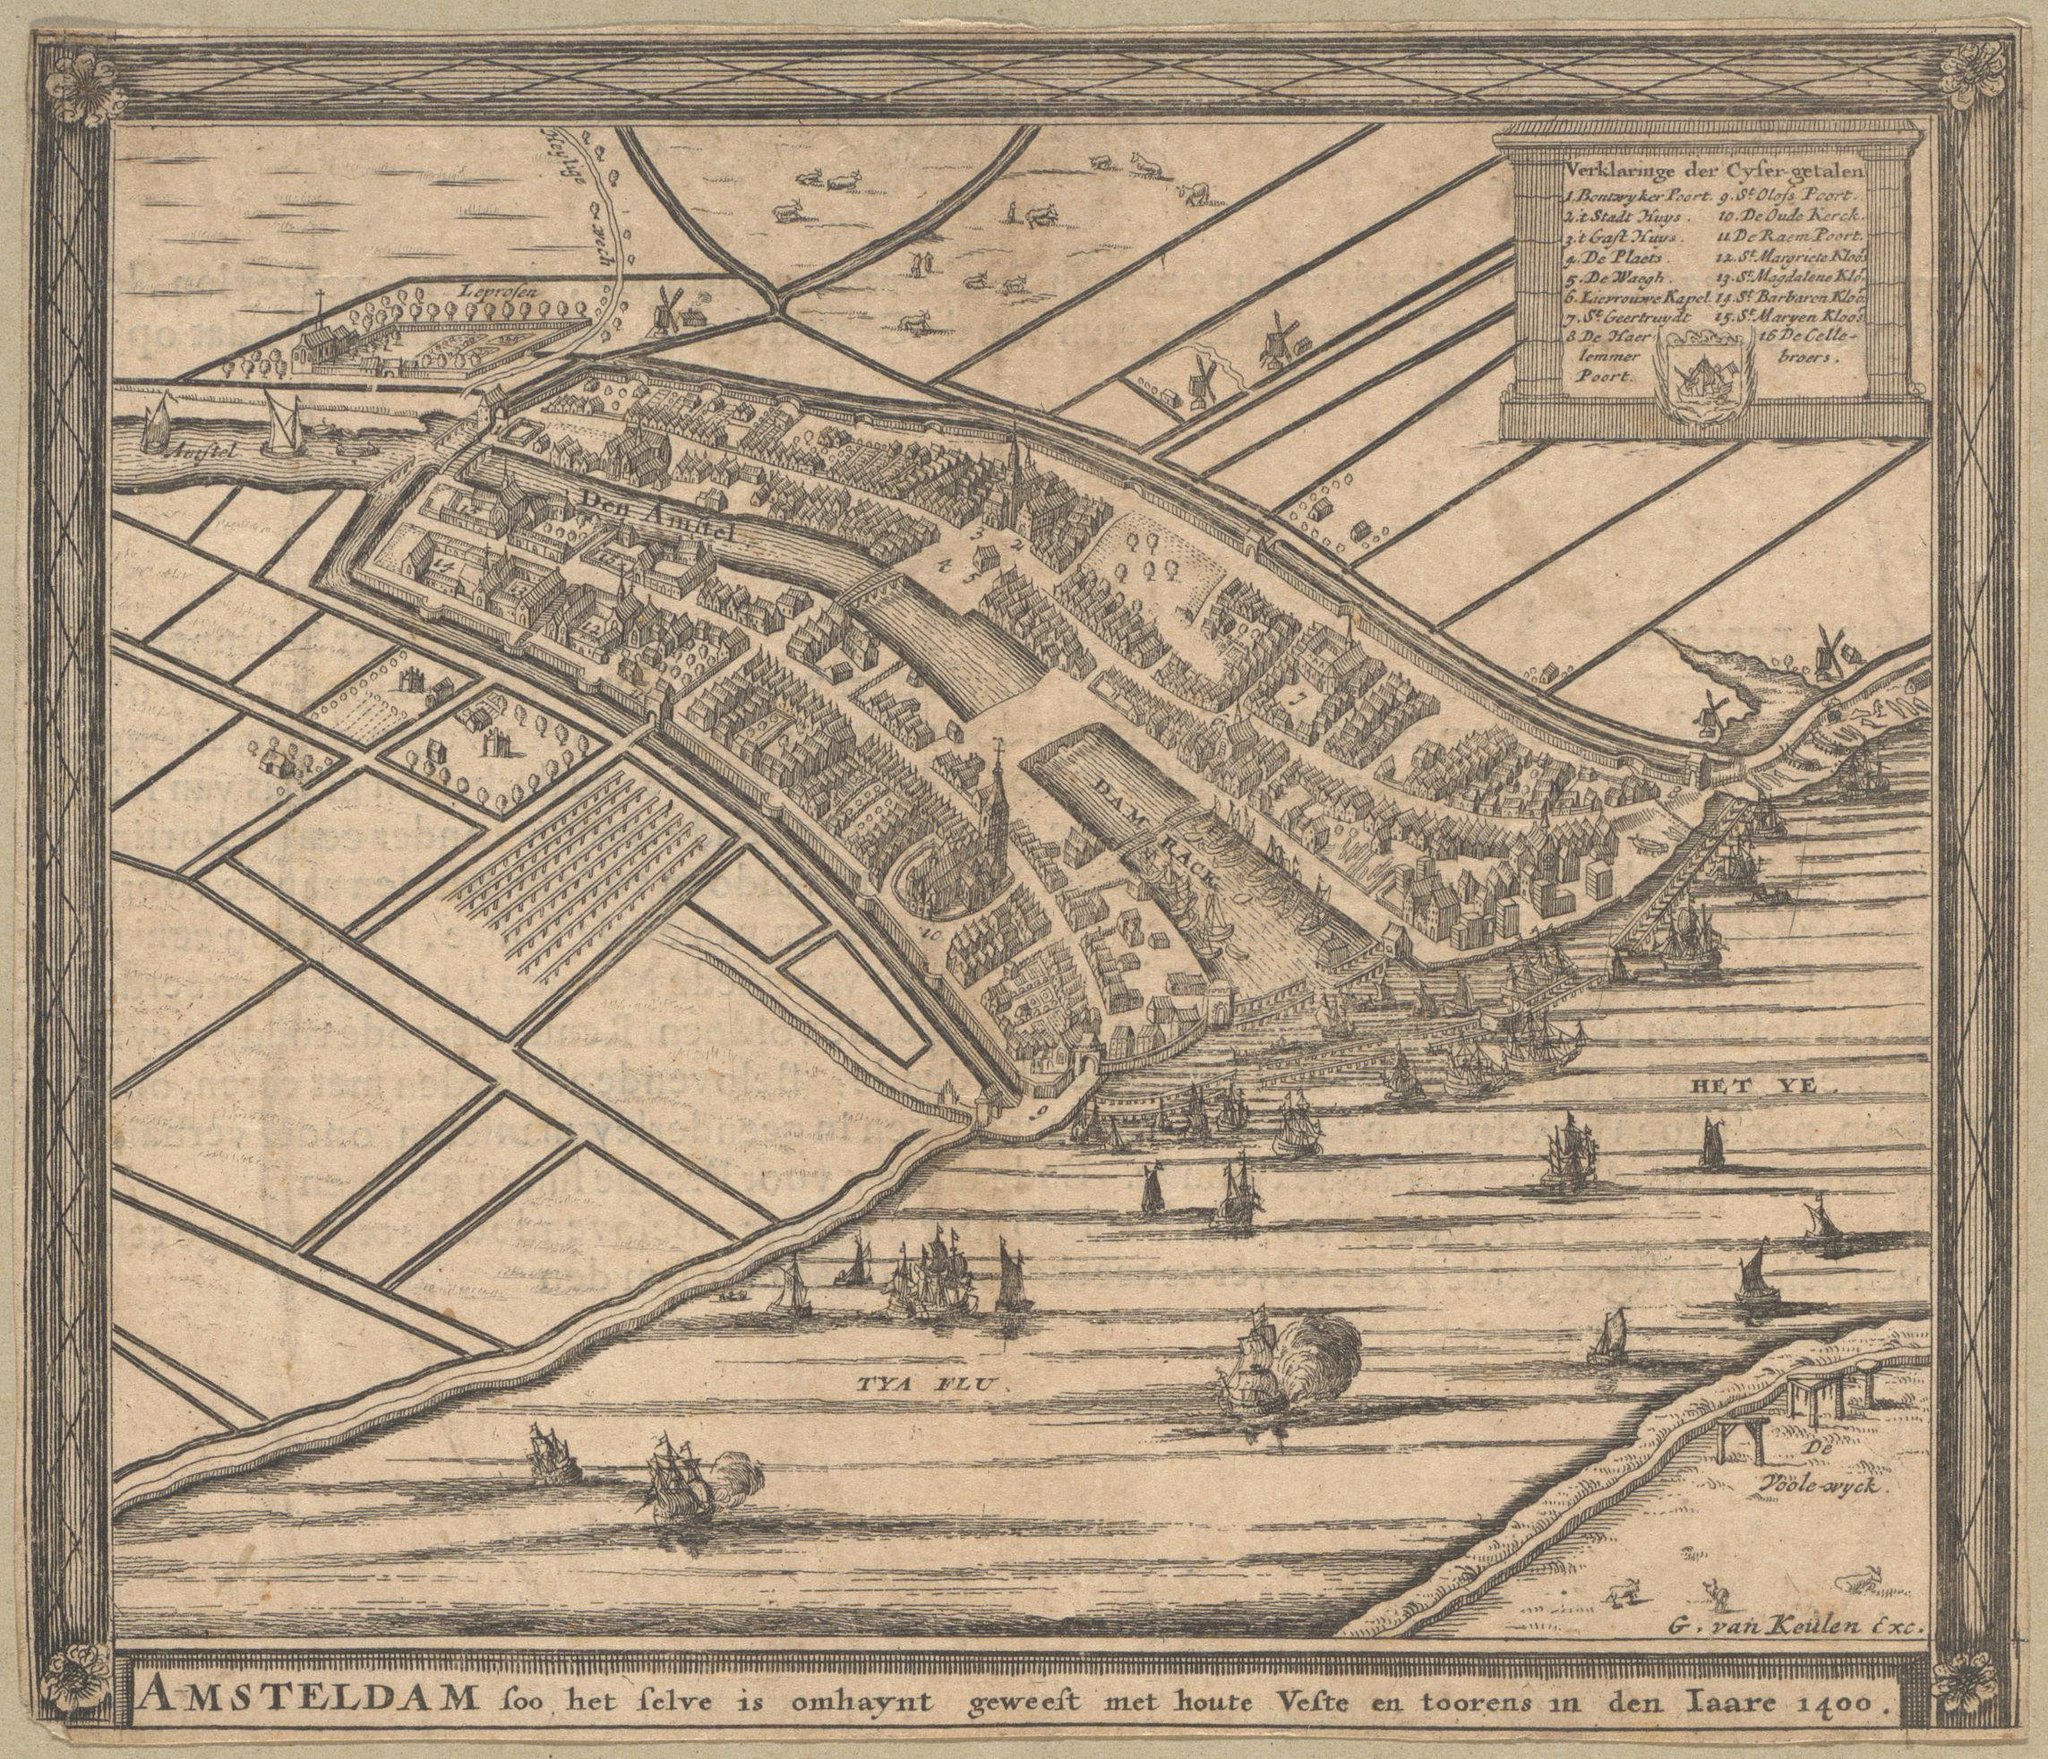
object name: map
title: Vijf historische kaarten van Amsterdam (De Ram / Van Keulen)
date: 1680-1727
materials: paper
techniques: engraving, etching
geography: amsterdam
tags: coat of arms (as symbol of the state, etc.) (+ city; municipal), maps of cities, amsterdam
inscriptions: collector's mark: Lugt 1641b